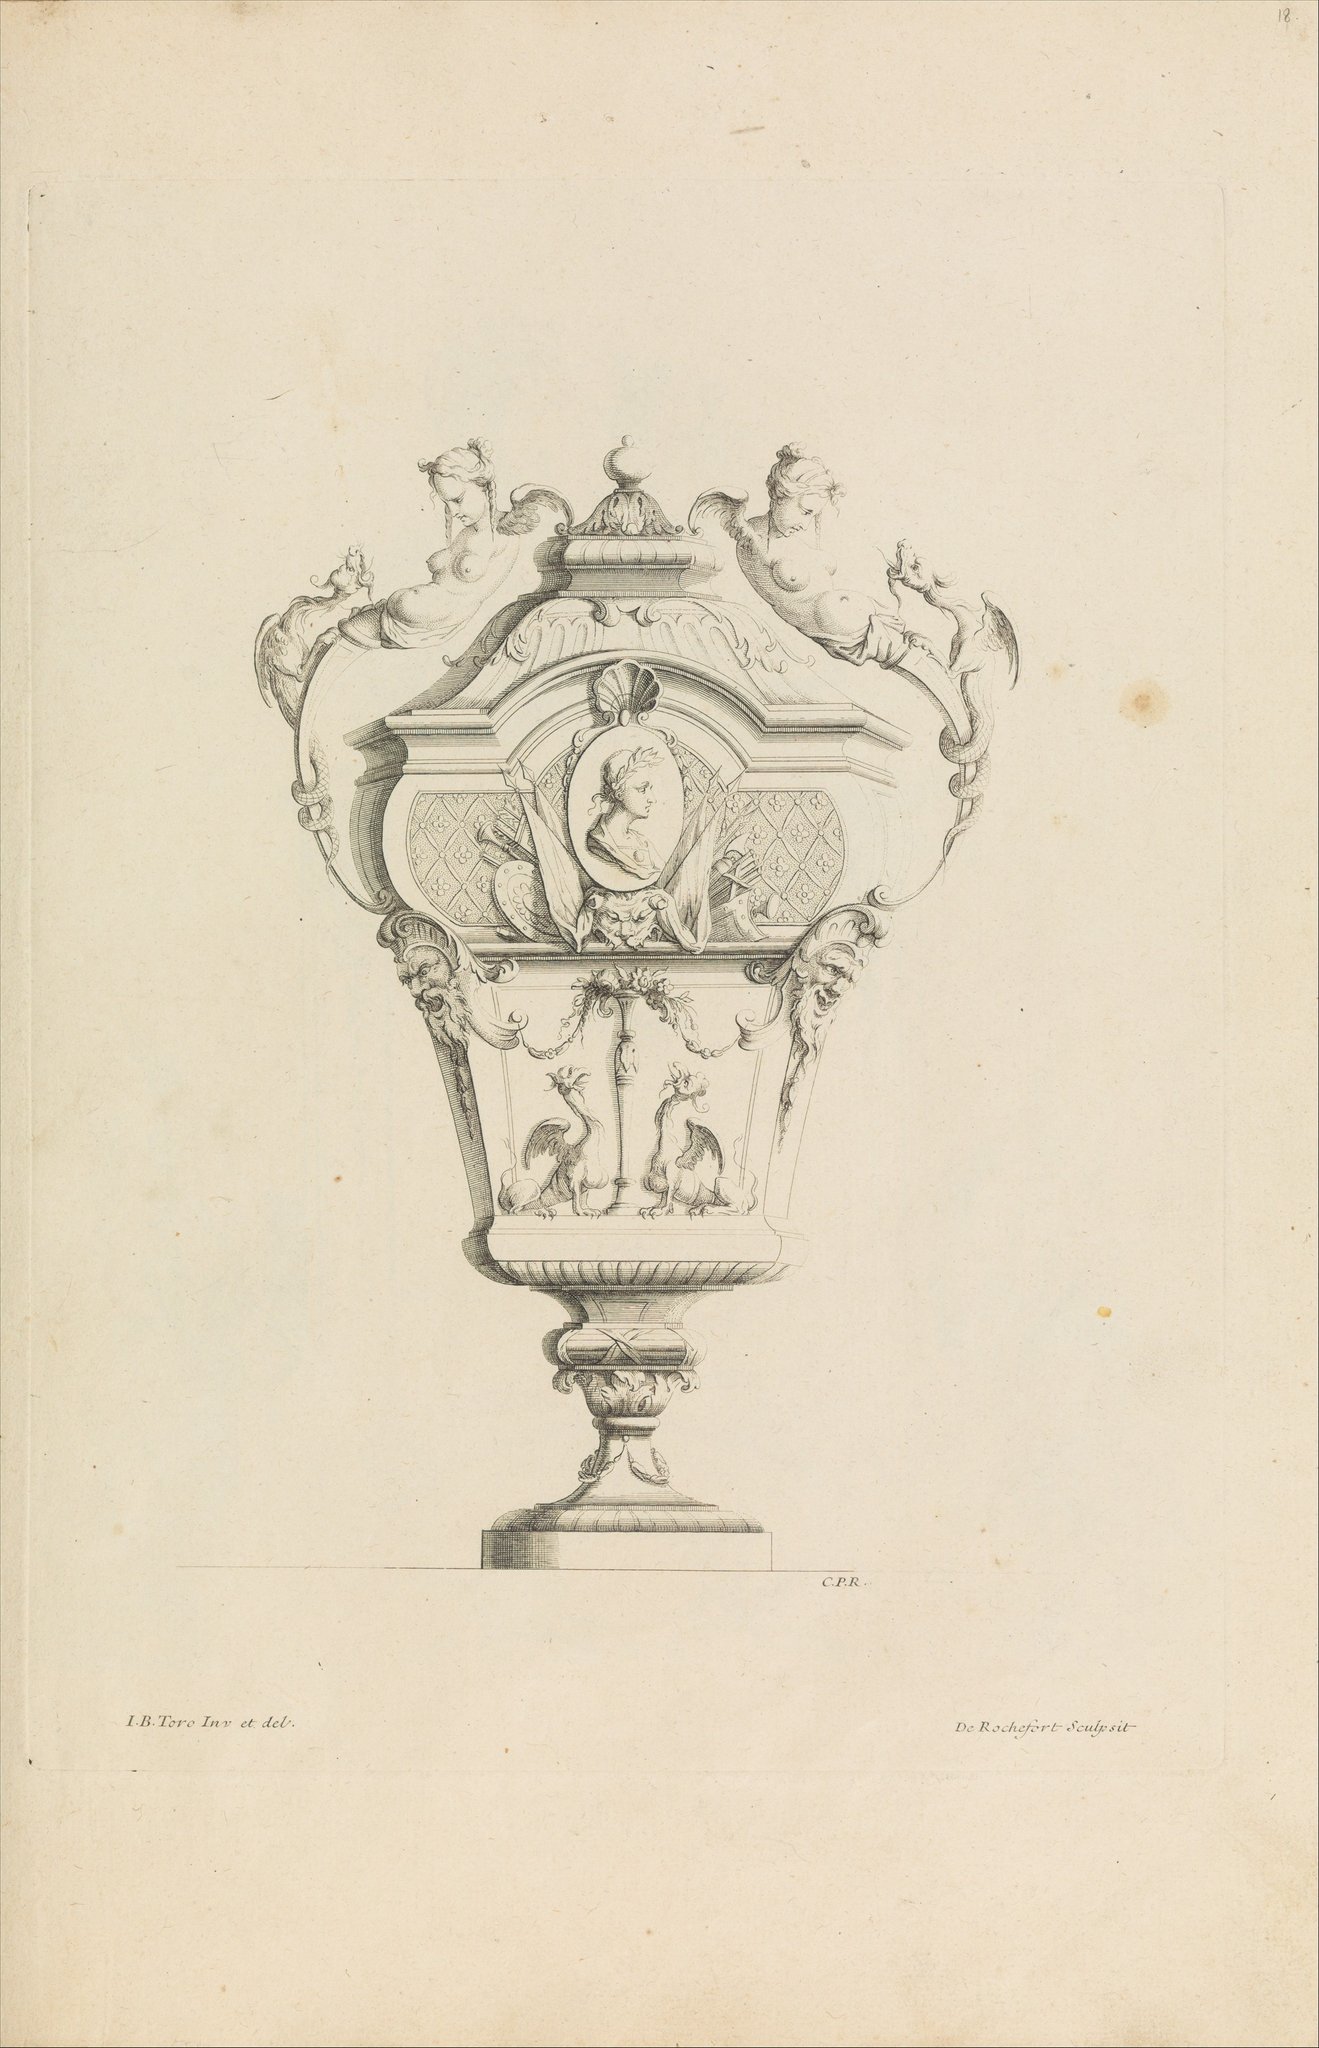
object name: album print ornament architecture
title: Nouveau Livre de Vases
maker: jean bernard toro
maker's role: designer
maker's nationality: french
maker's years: 1672-1731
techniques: etching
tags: profiles,female nudes,dragons,vases